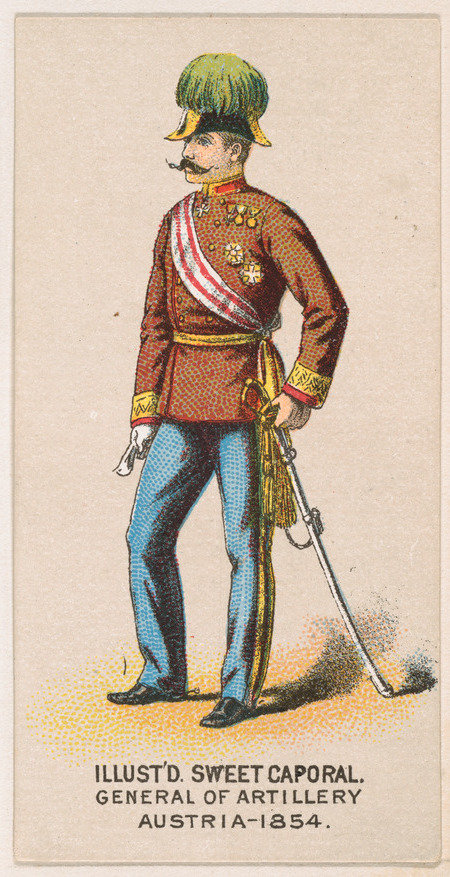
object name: print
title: General of Artillery, Austria, 1854, from the Military Series (N224) issued by Kinney Tobacco Company to promote Sweet Caporal Cigarettes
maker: kinney brothers tobacco company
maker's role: publisher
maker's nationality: american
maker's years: 1869-2011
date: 1888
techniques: color lithograph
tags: military,men,generals